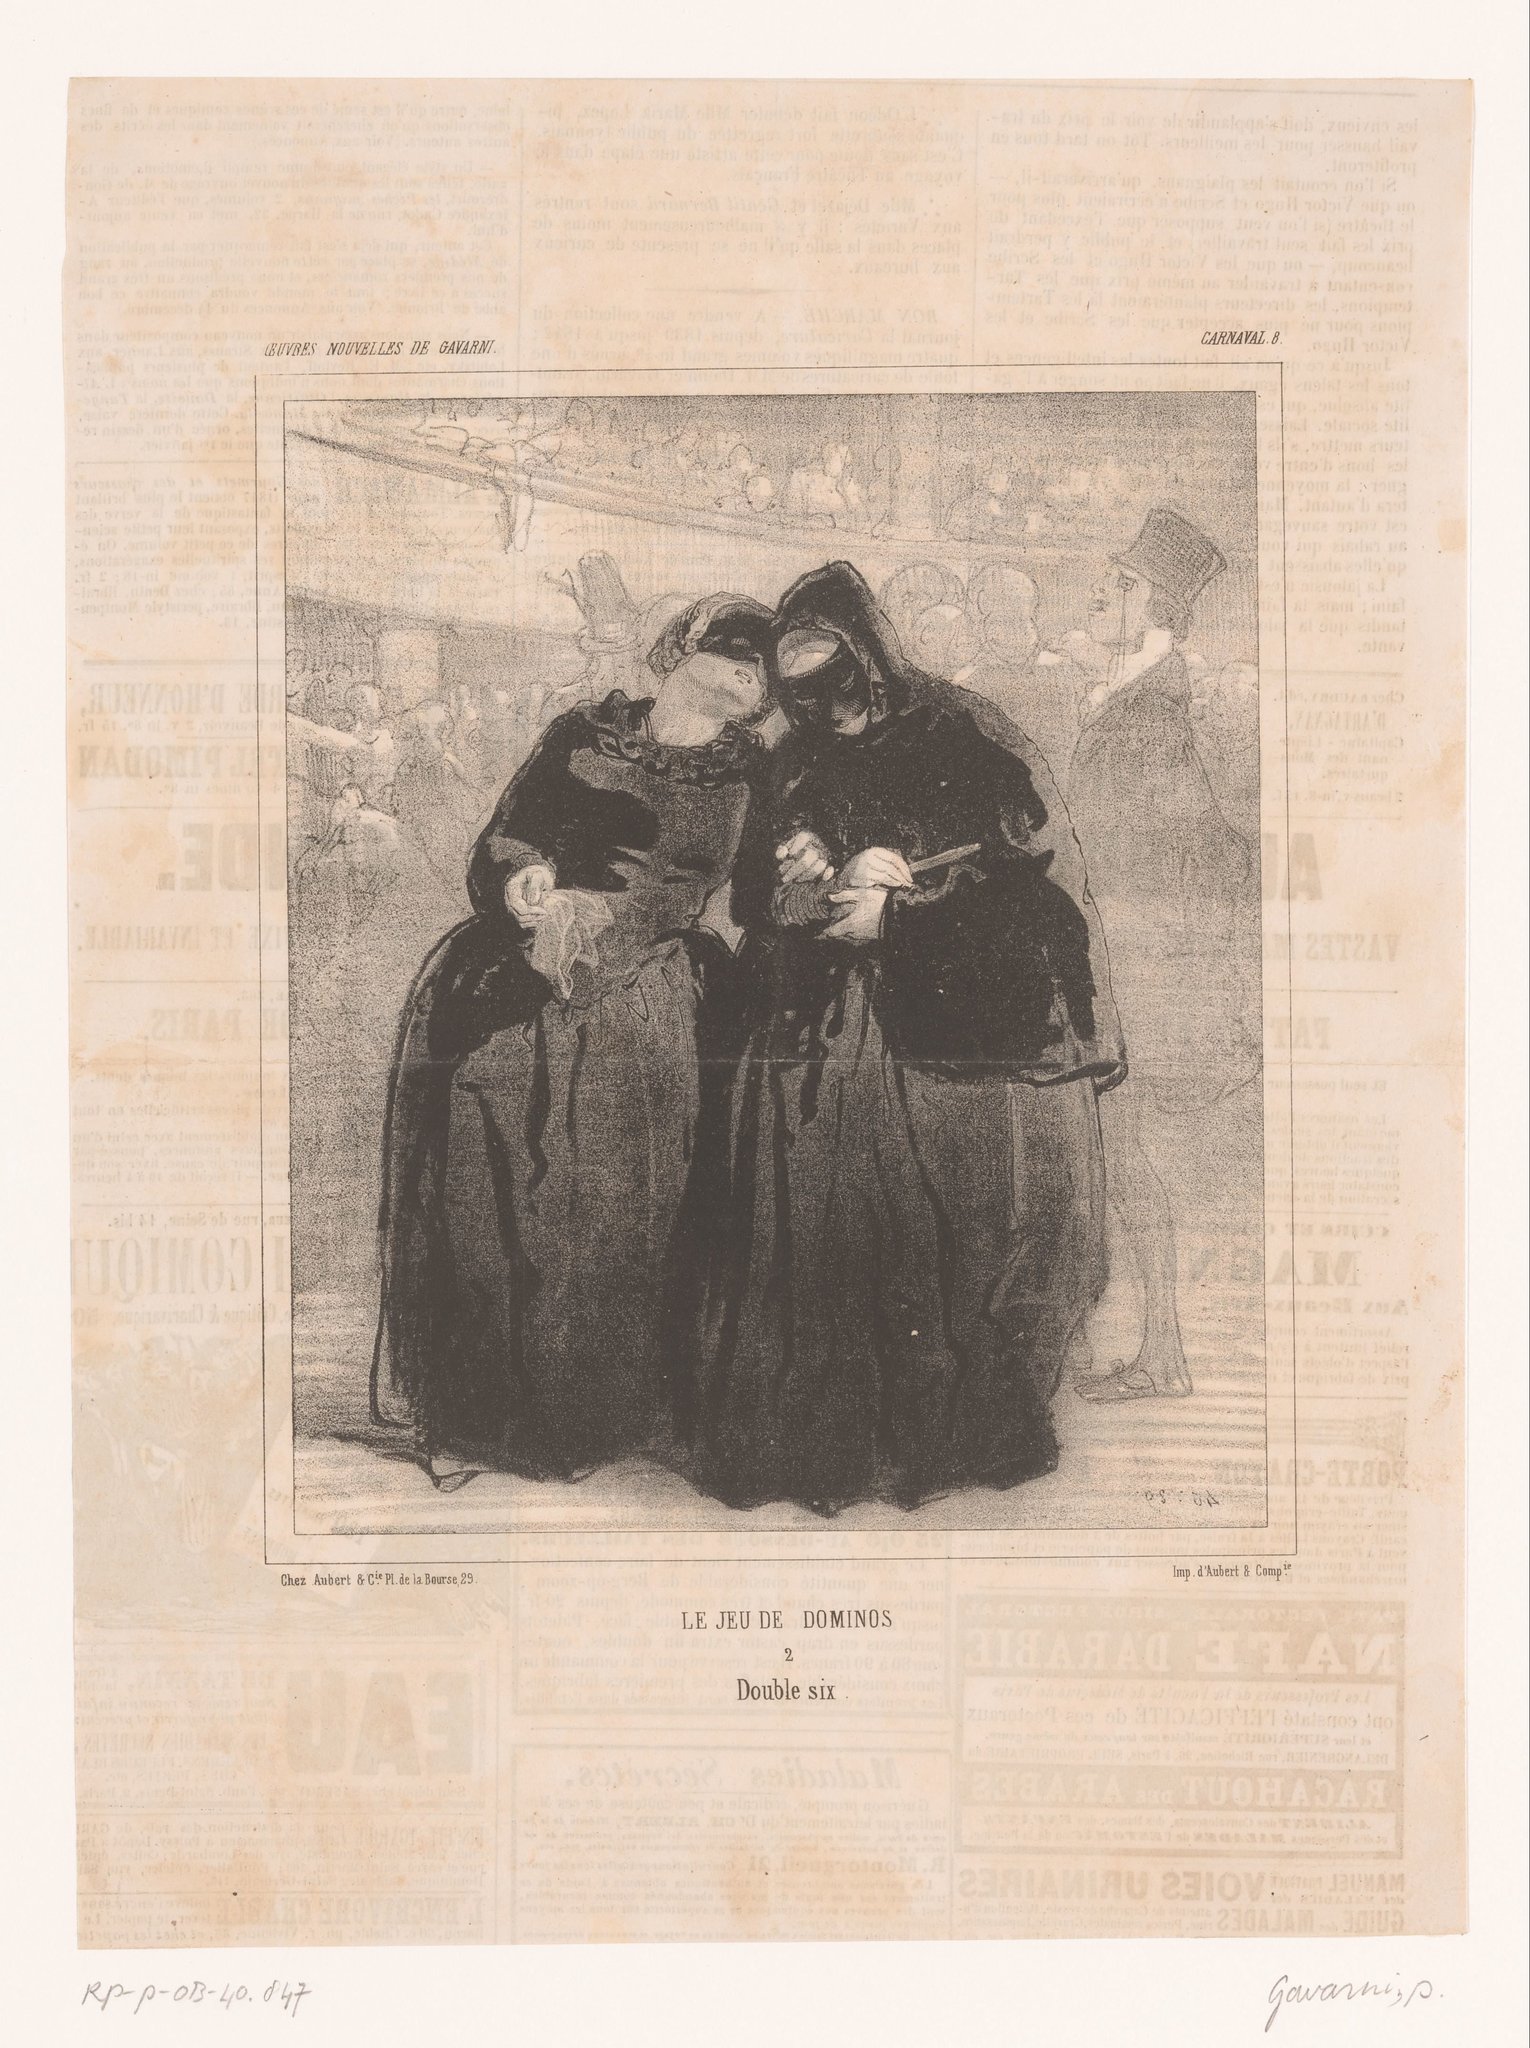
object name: cartoon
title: Twee gemaskerde vrouwen op een carnavalsbal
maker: paul gavarni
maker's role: draughtsman, print maker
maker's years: 1804-1866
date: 1846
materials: paper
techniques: lithograph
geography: paris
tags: masquerade, masked ball, carnival, shrovetide (non-liturgical celebration)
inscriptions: collector's mark: Lugt 2228a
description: Prent gebruikt voor: Le Charivari, 15 december 1846.